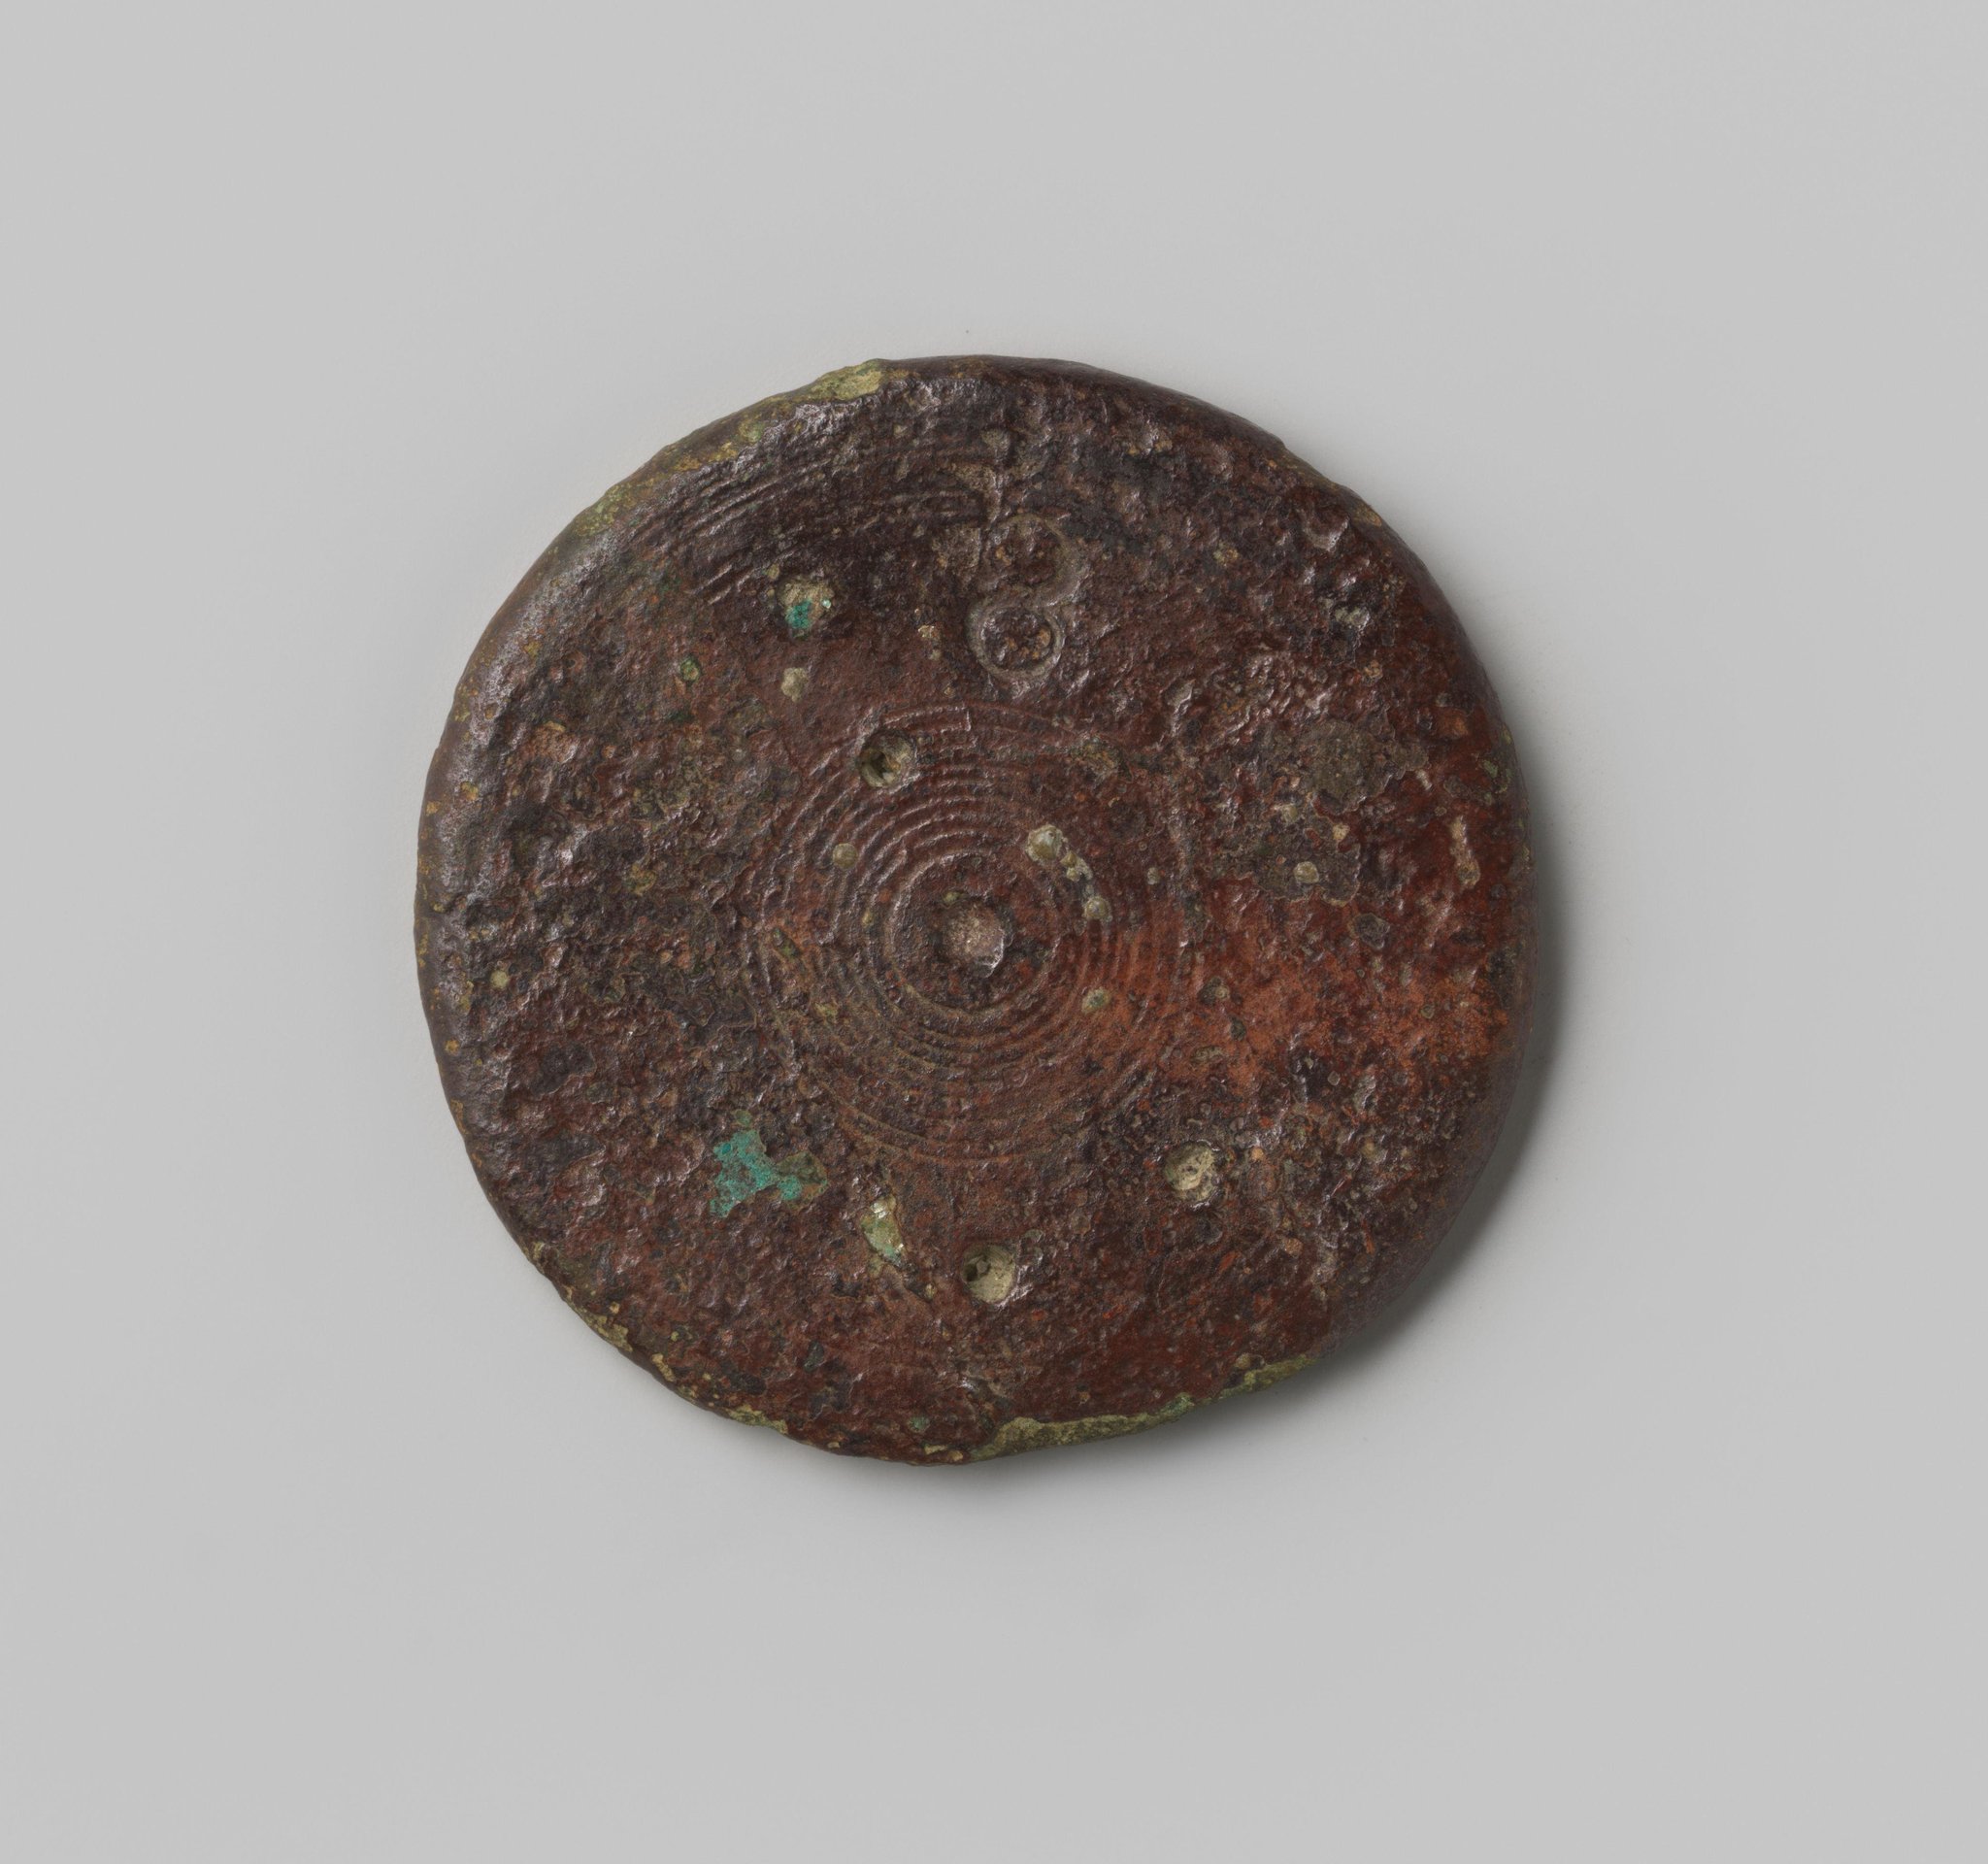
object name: lid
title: Deksel van een sluitgewicht uit het wrak van de Oost-Indiëvaarder Hollandia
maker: Anonymous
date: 1700-1743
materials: copper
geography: netherlands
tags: verenigde oostindische compagnie, hollandia (schip), annet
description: Weight, cupweight, lid; id. NG 1980-27H33, eroded, 1 mark id. NG 1980-27H2892 legible.